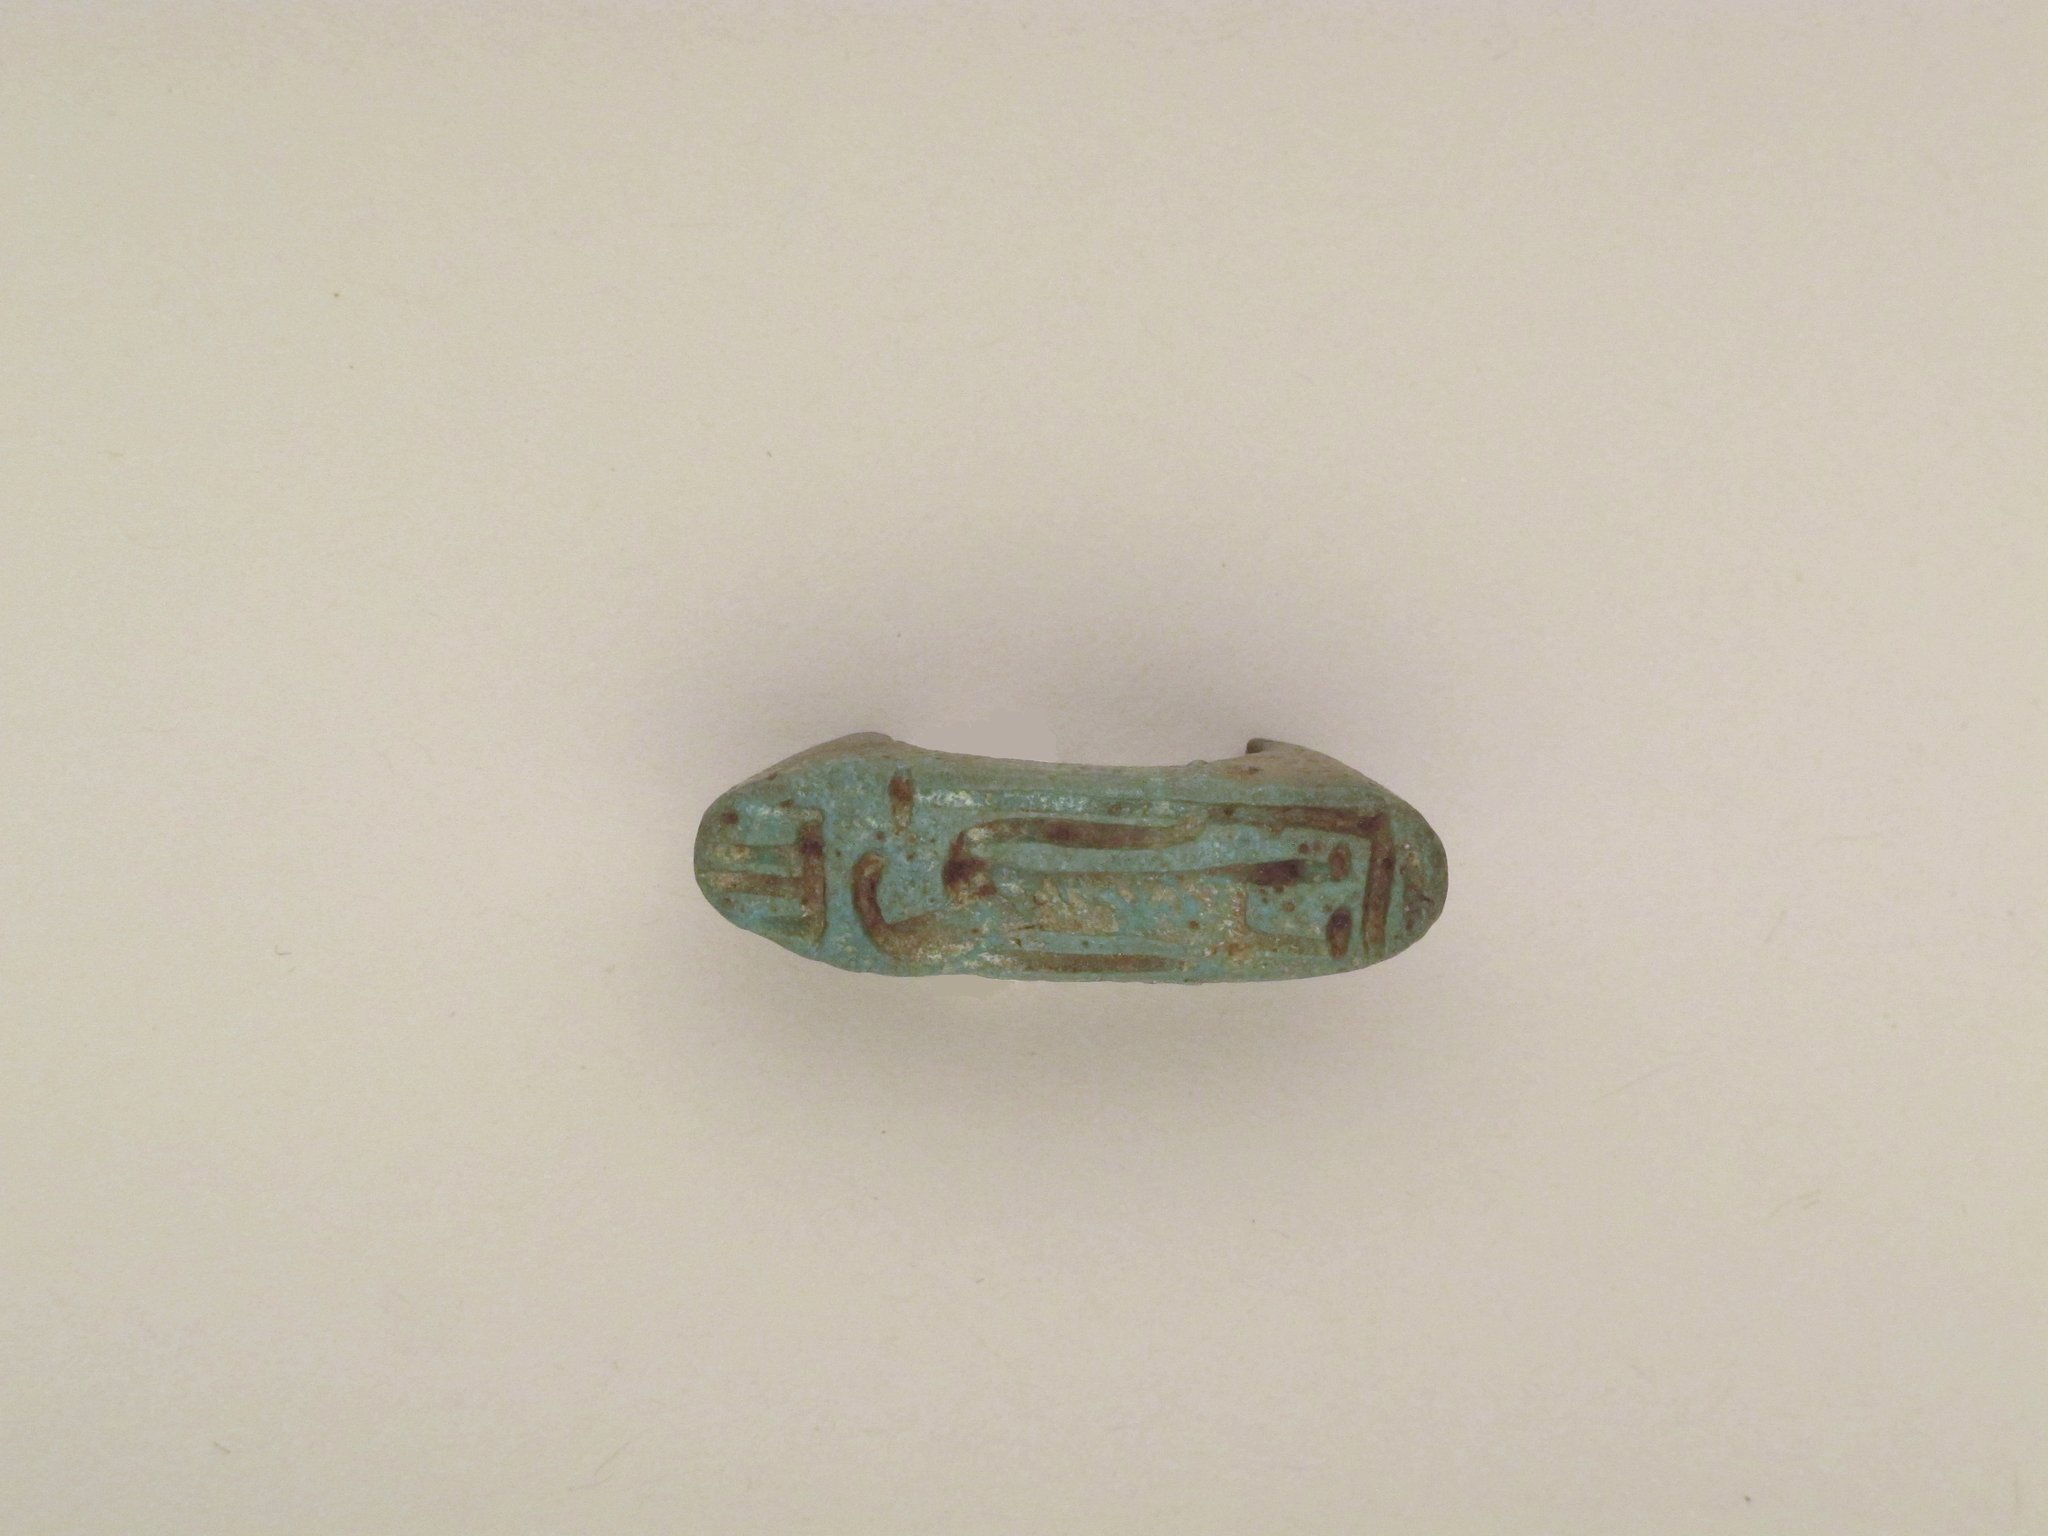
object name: ring, glazed signet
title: Faience cartouche ring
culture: egyptian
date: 664-630 BCE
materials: faience